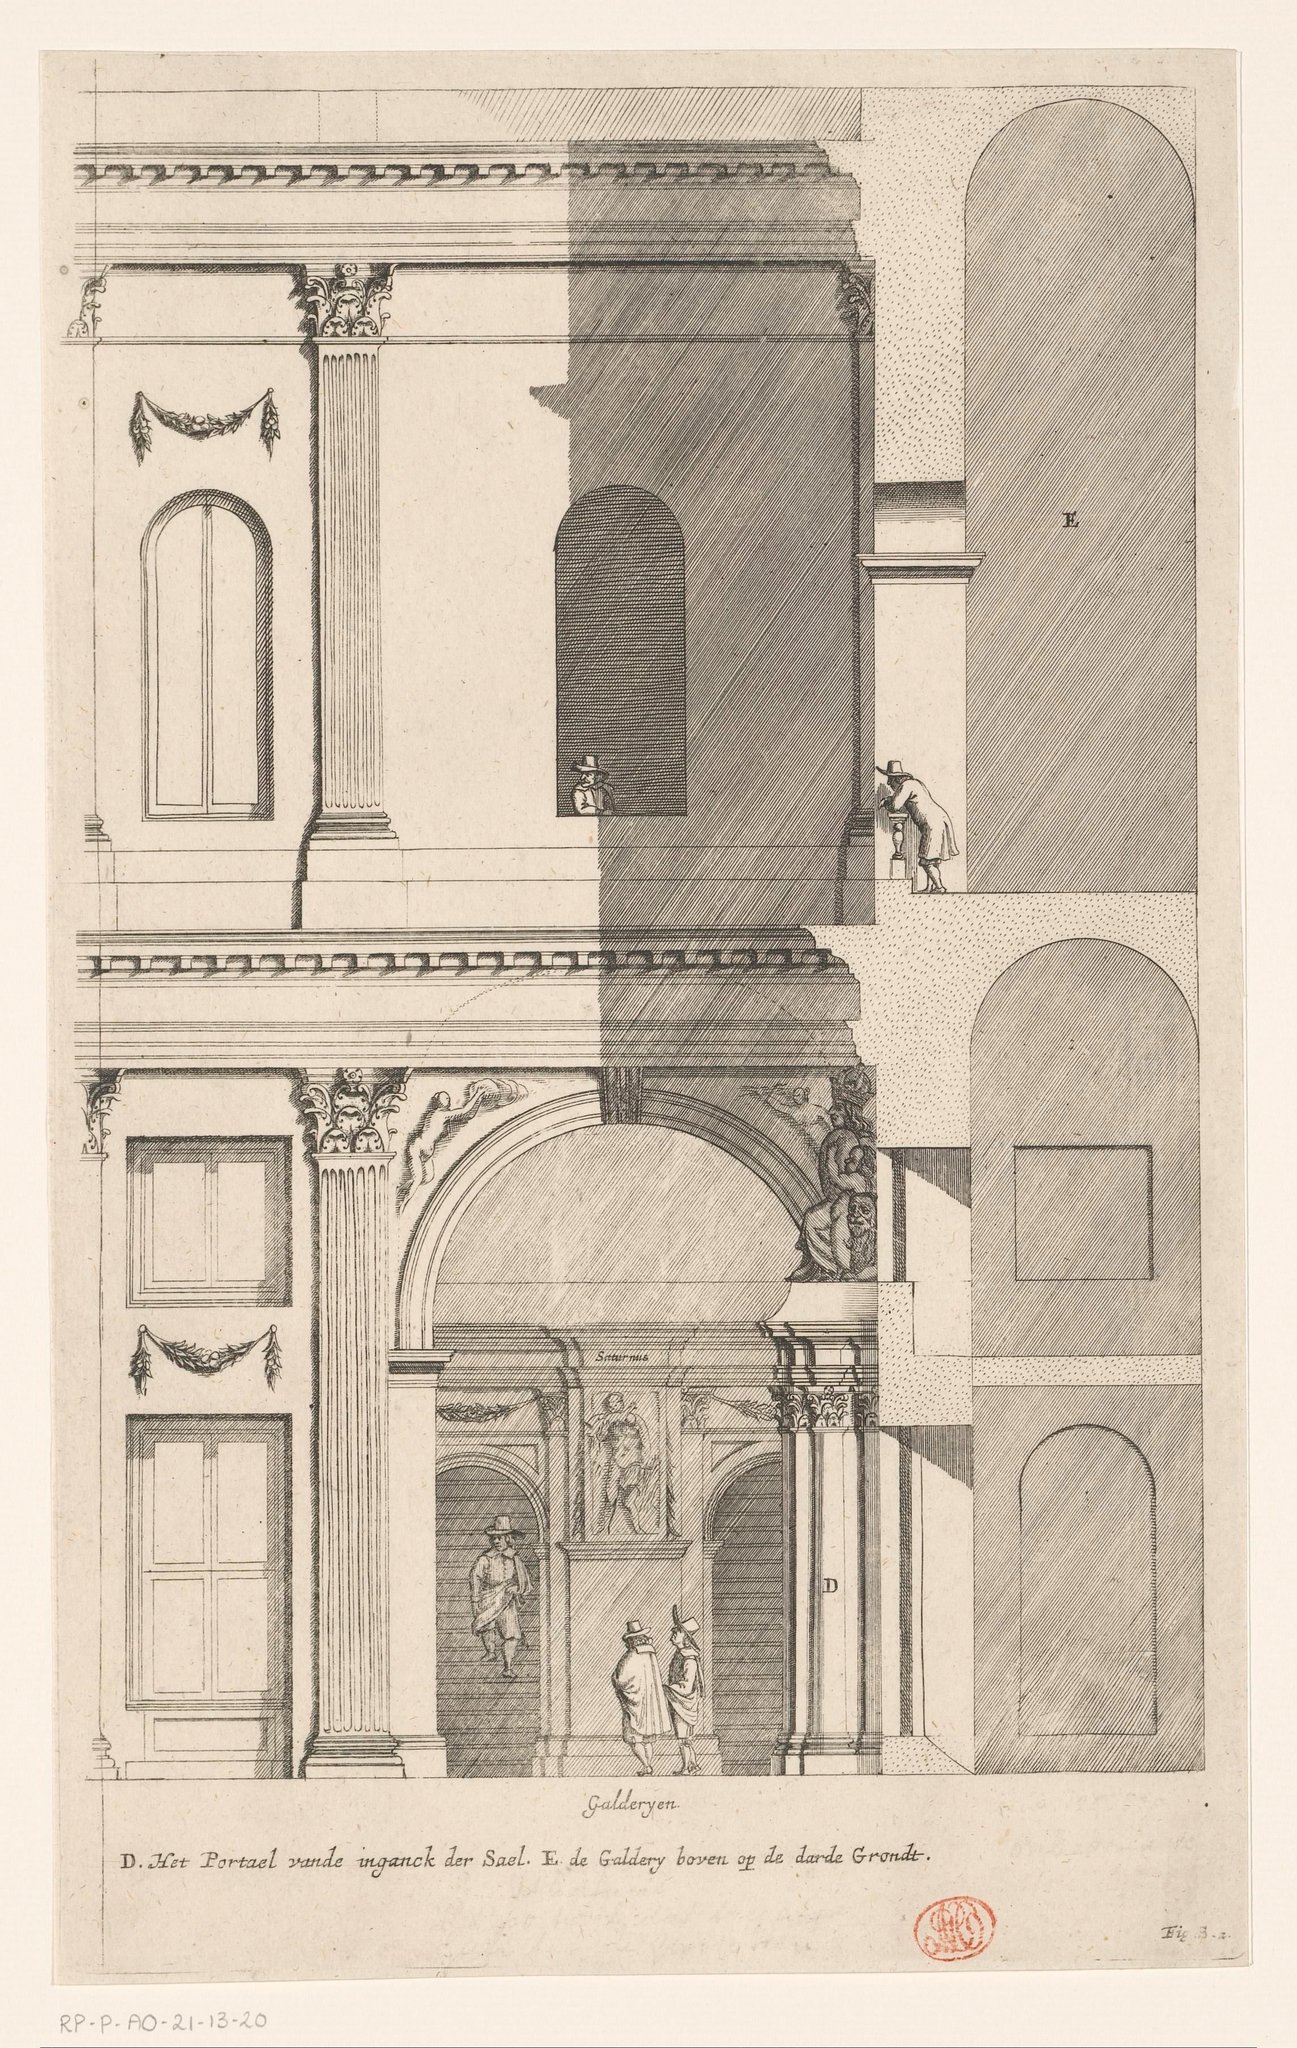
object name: book illustration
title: Noordzijde van de Burgerzaal in het Stadhuis op de Dam (rechterdeel)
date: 1661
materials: paper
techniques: engraving, etching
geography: amsterdam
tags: interior ~ architectural design or model, townhall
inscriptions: collector's mark: Lugt 195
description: Rechterdeel van een prent van de noordzijde van de Burgerzaal in het Stadhuis op de Dam te Amsterdam, bestaande uit twee delen. Onder de legenda D-E. Rechtsonder gemerkt: Fig. S. 2.